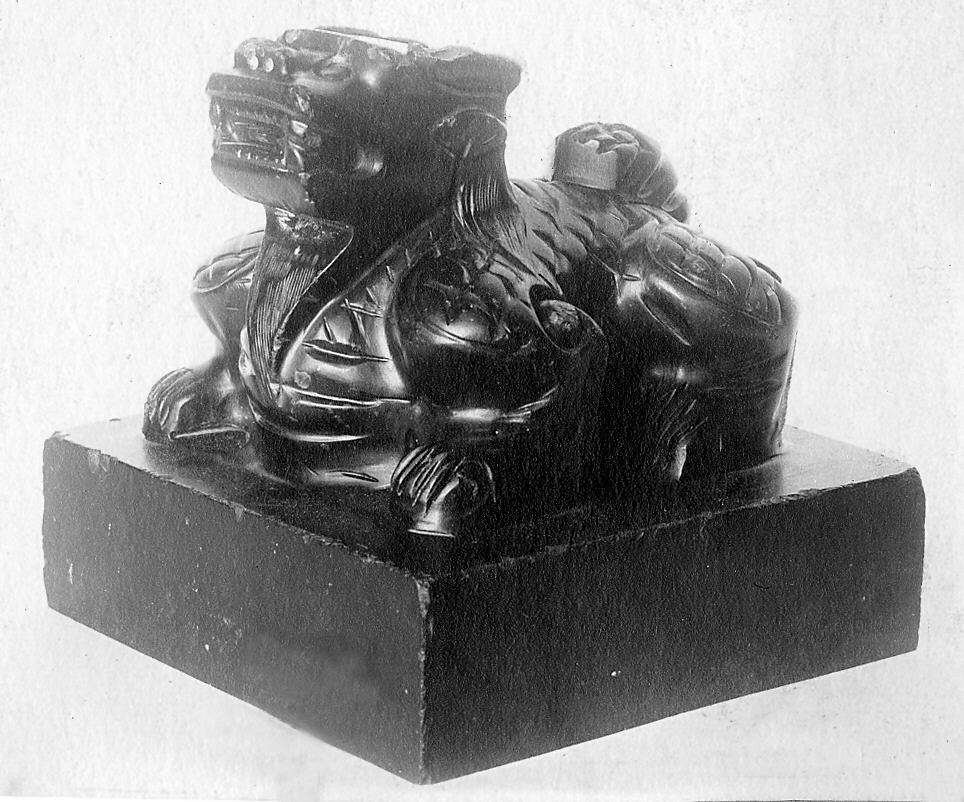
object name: seal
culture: chinese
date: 1621-1628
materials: jade